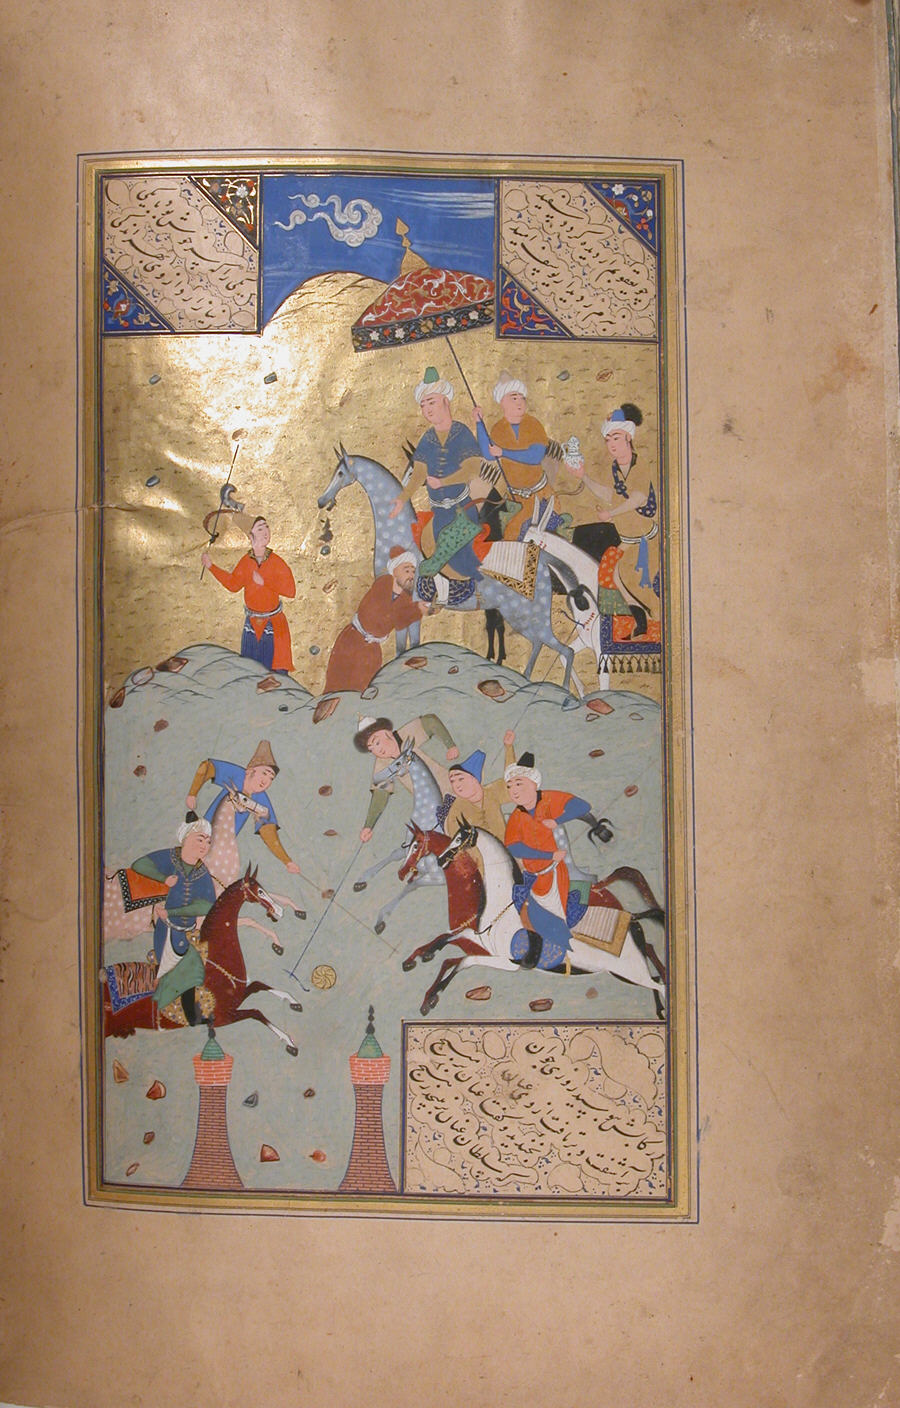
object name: illustrated manuscript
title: Bustan (Orchard) of Sa'di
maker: mir 'ali al-husaini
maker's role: calligrapher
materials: gold, ink, leather, paper, watercolor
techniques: bookbinding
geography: uzbekistan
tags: men,women,horses